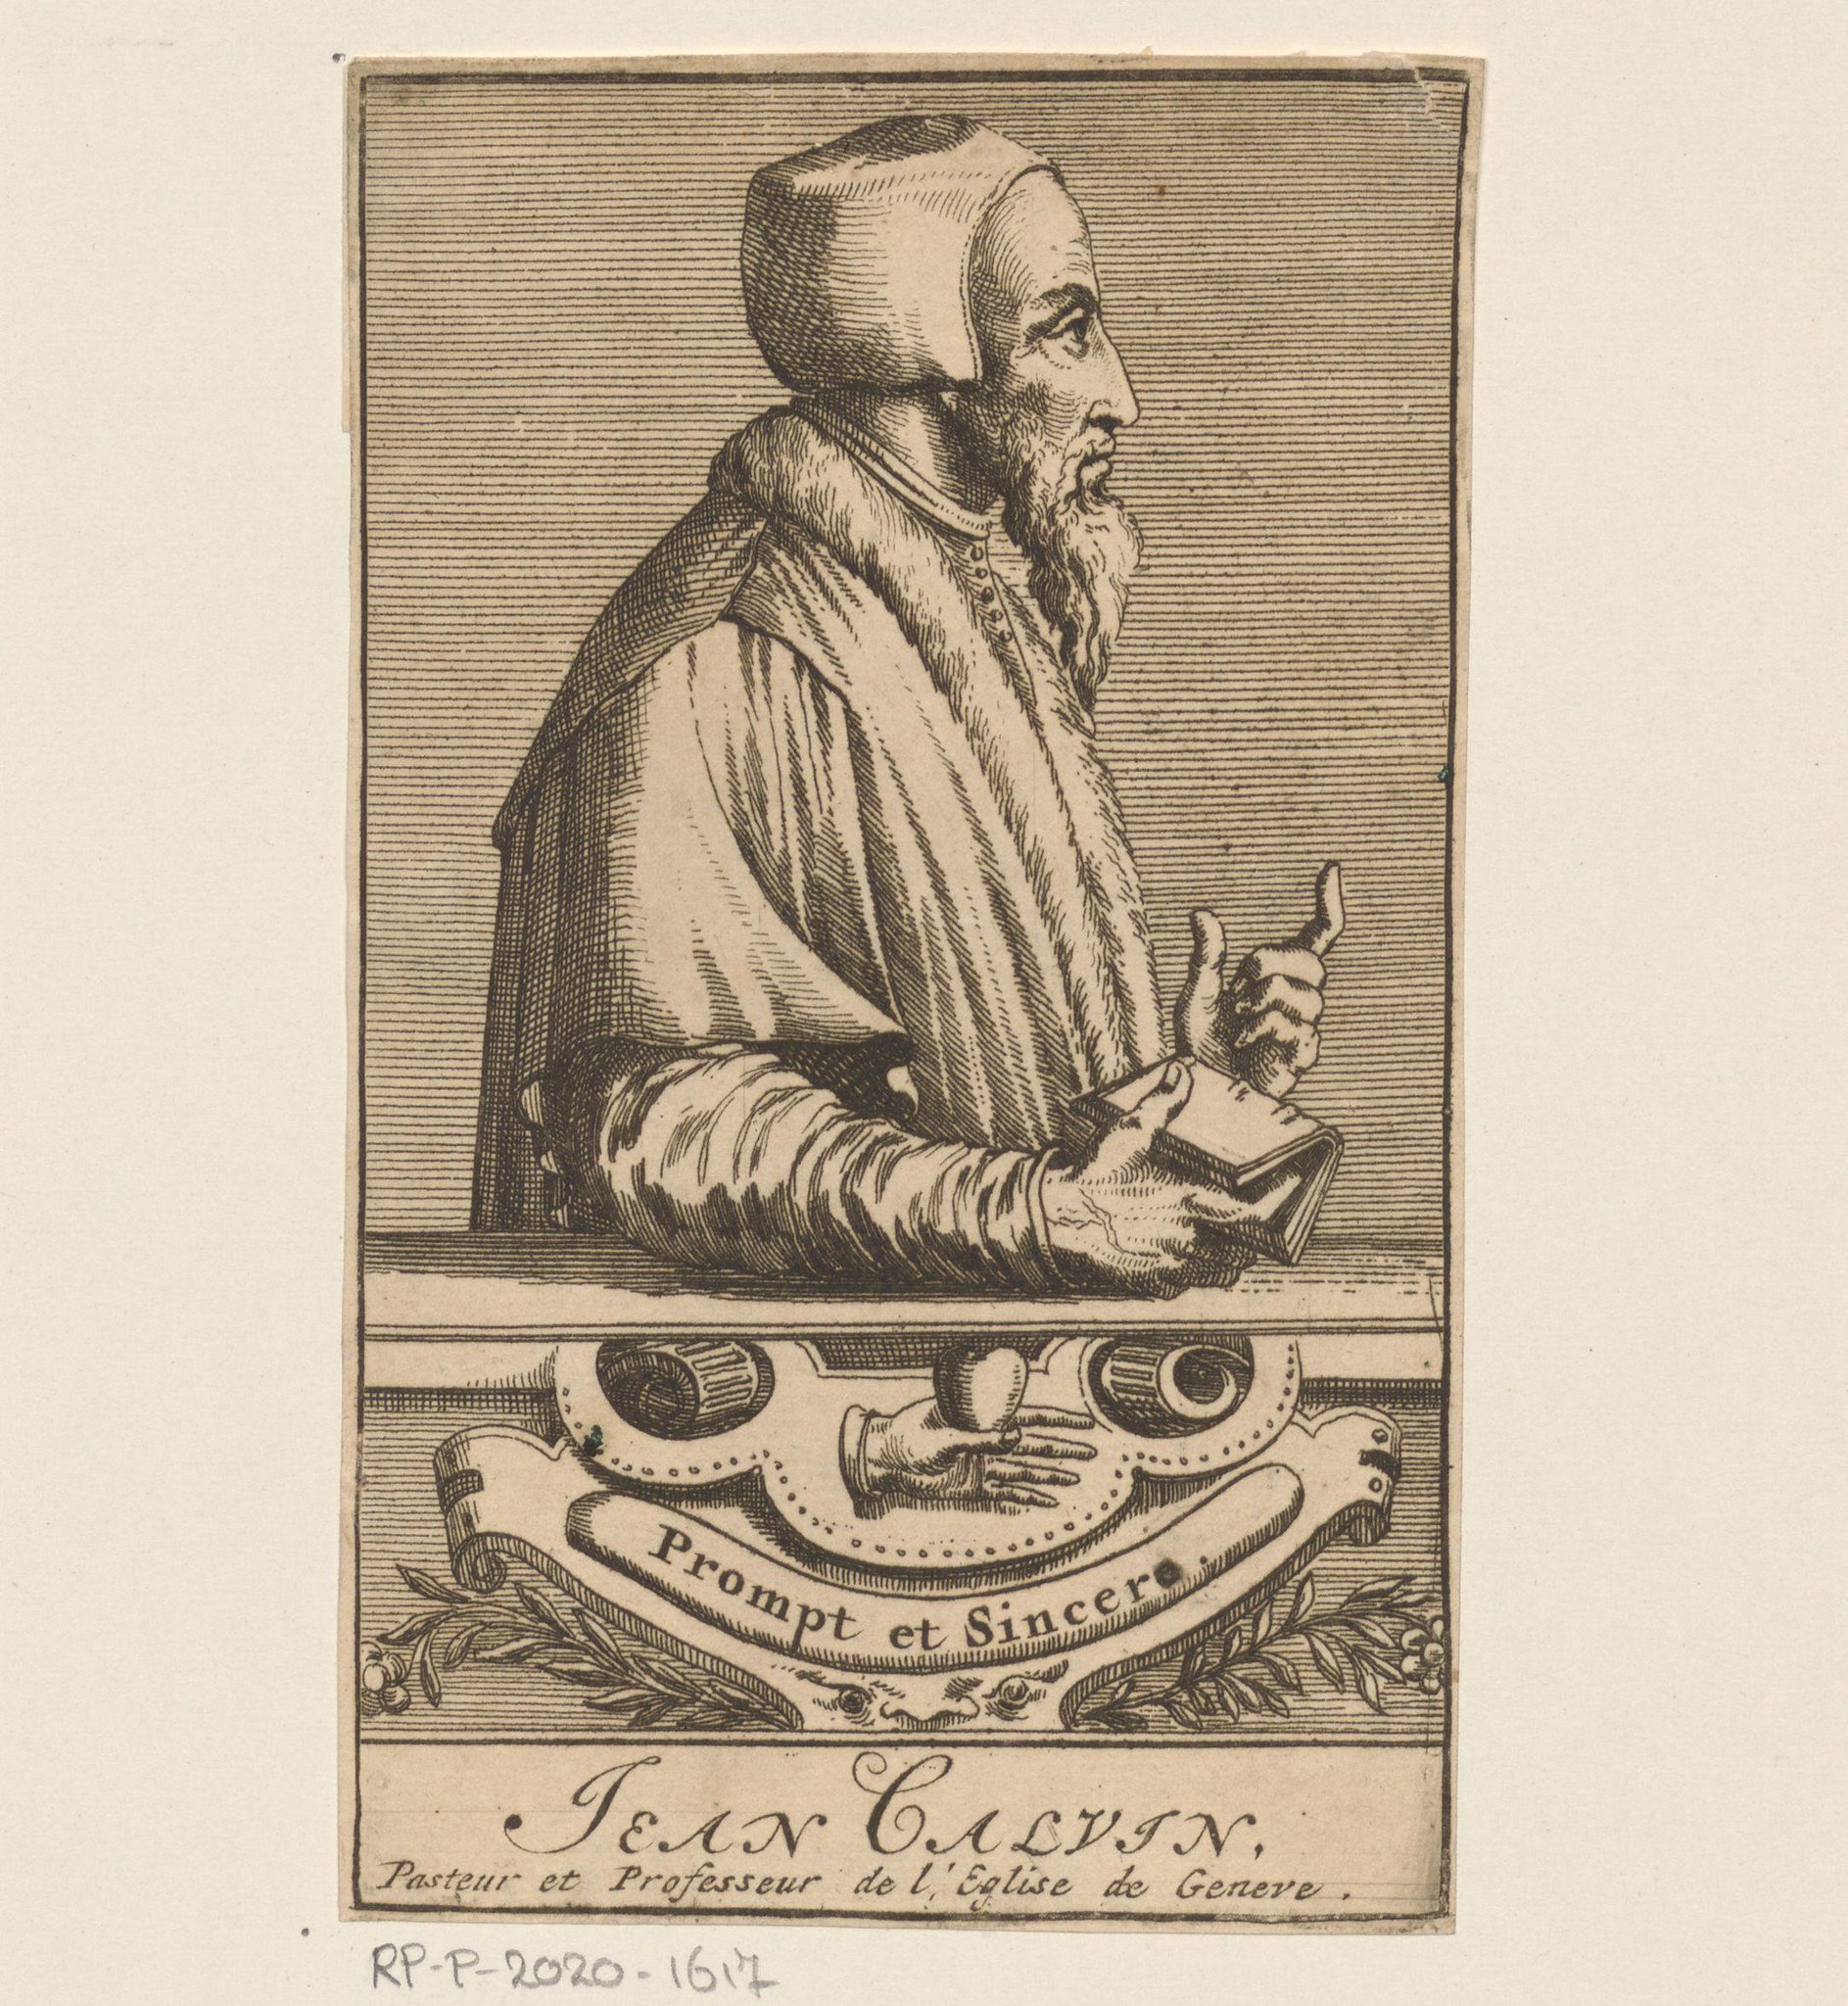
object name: print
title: Portret van Johannes Calvijn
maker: Anonymous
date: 1650-1749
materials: paper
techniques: engraving, etching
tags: historical persons